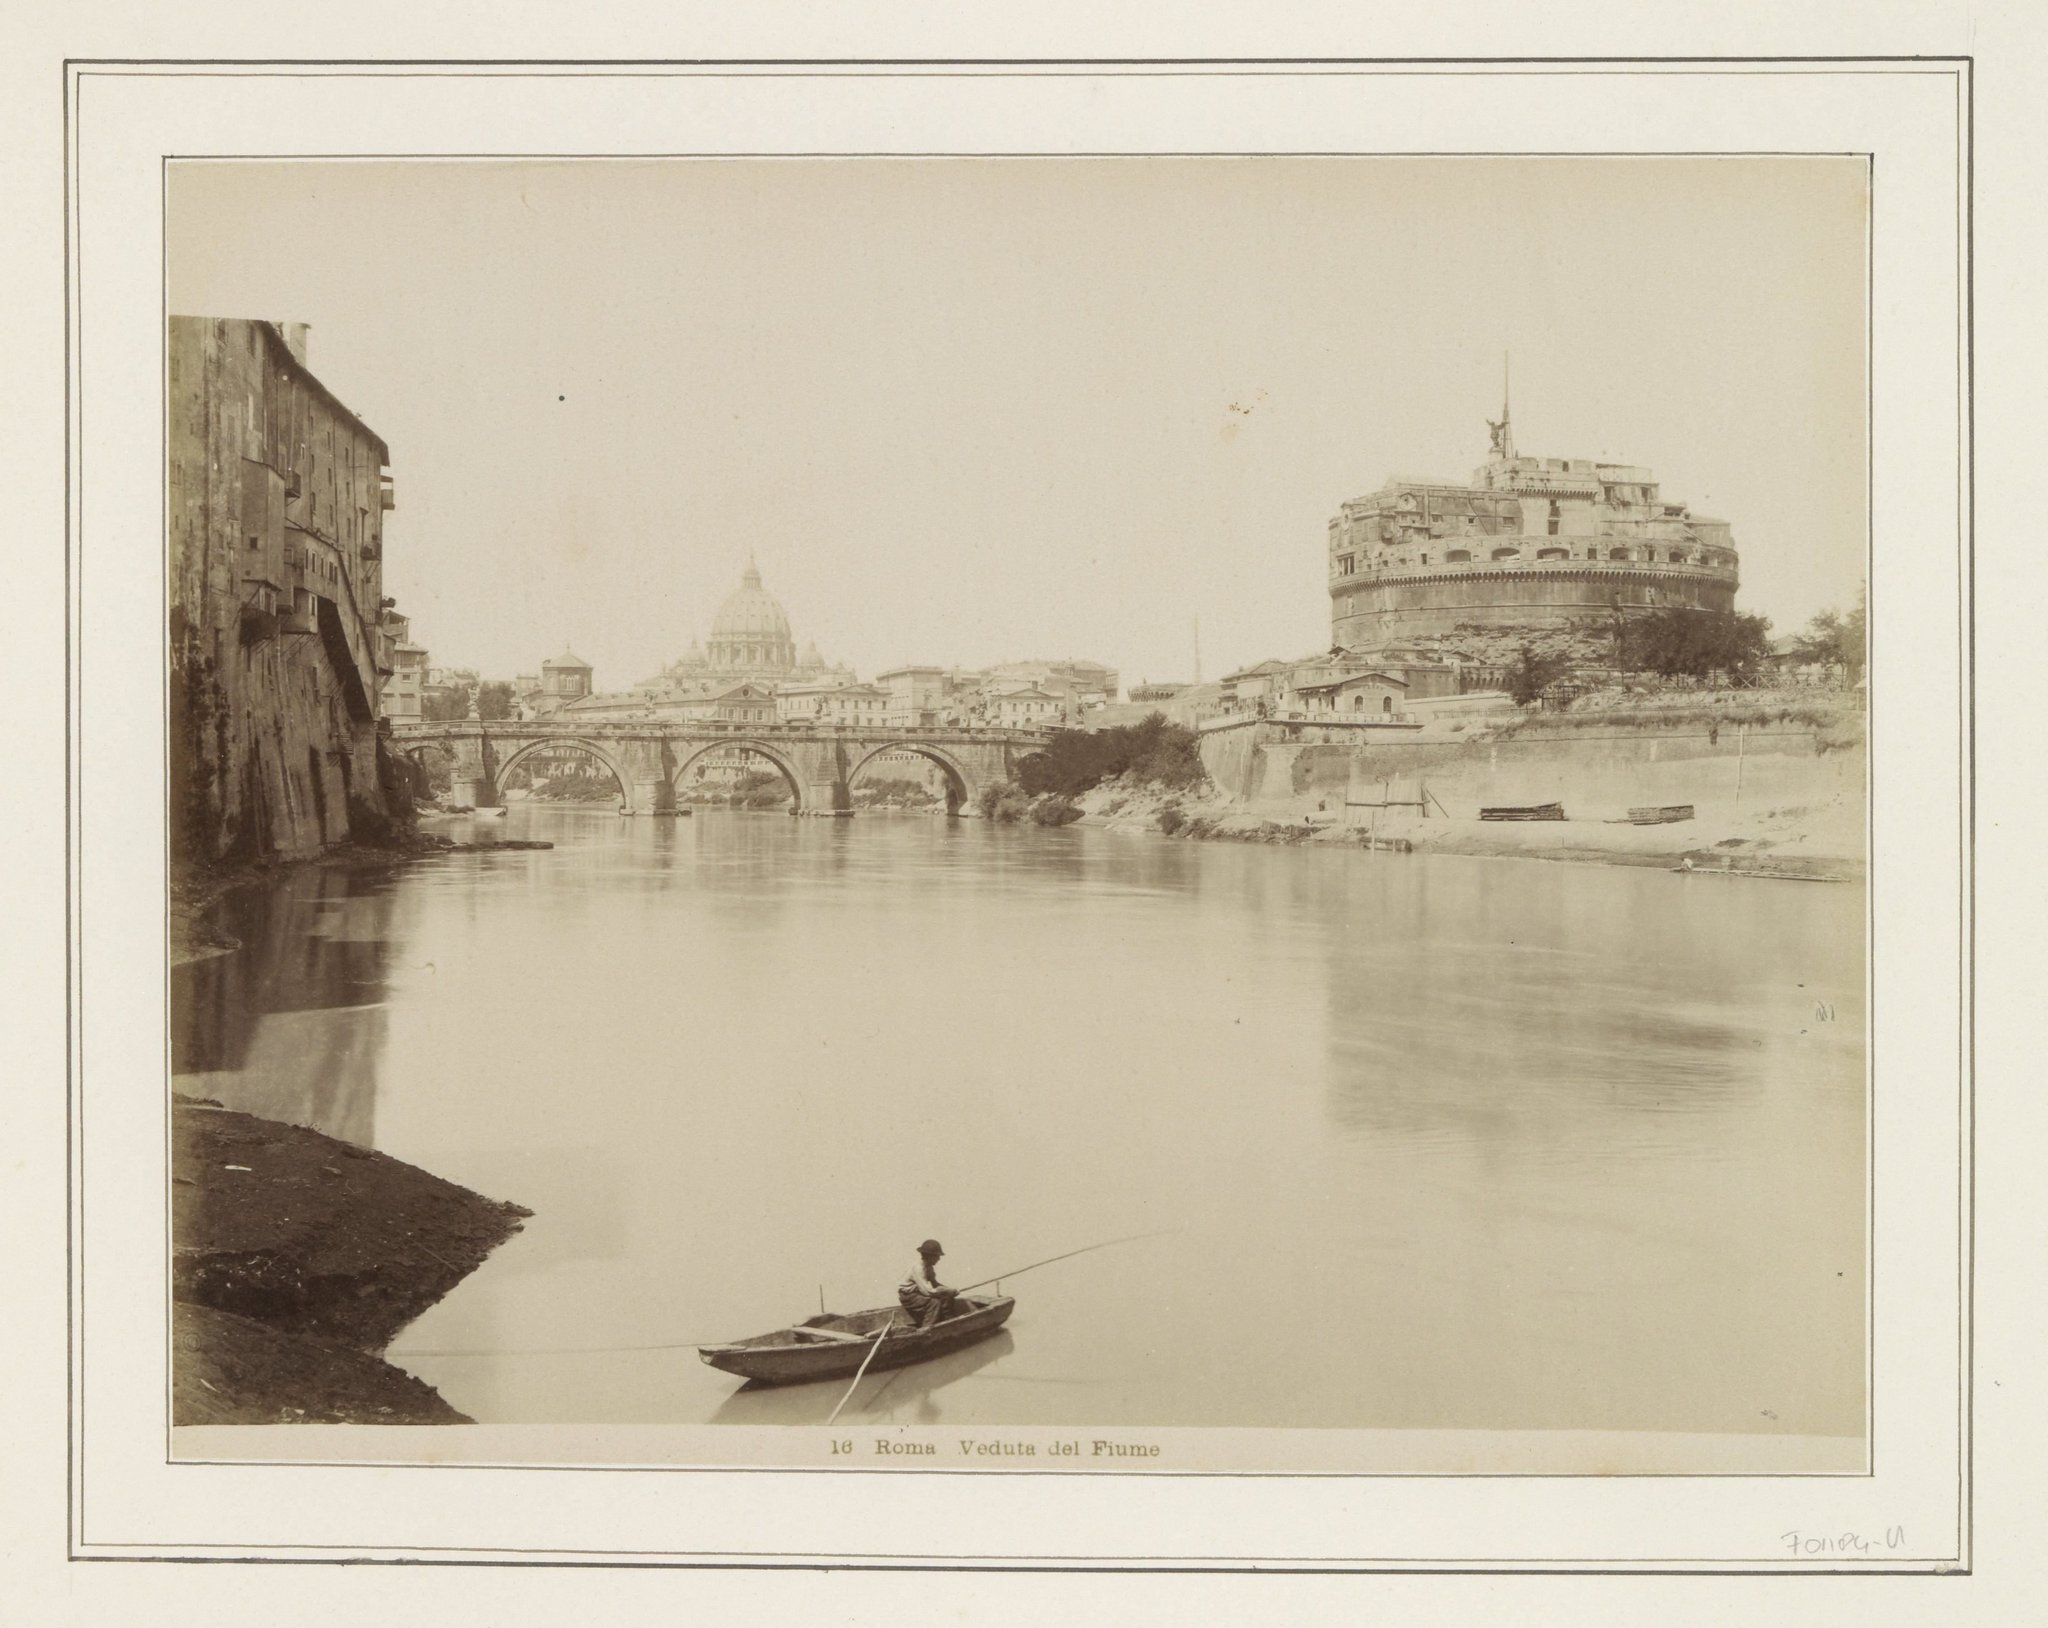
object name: photograph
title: Roma Veduta del Fiume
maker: Anonymous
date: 1865-1890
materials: paper, photographic support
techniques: albumen print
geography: rome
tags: prospect of city, town panorama, silhouette of city, rome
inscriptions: negative number: ‘16’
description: Onderdeel van Reisalbum met foto's van bezienswaardigheden in Italië (deel I).